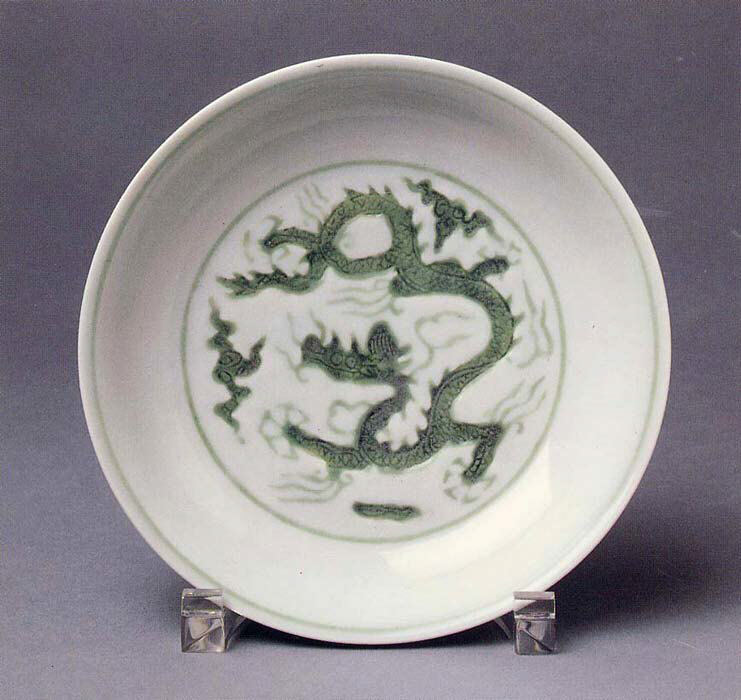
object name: dish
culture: chinese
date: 1506-1521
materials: enamel, porcelain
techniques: incising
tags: dragons